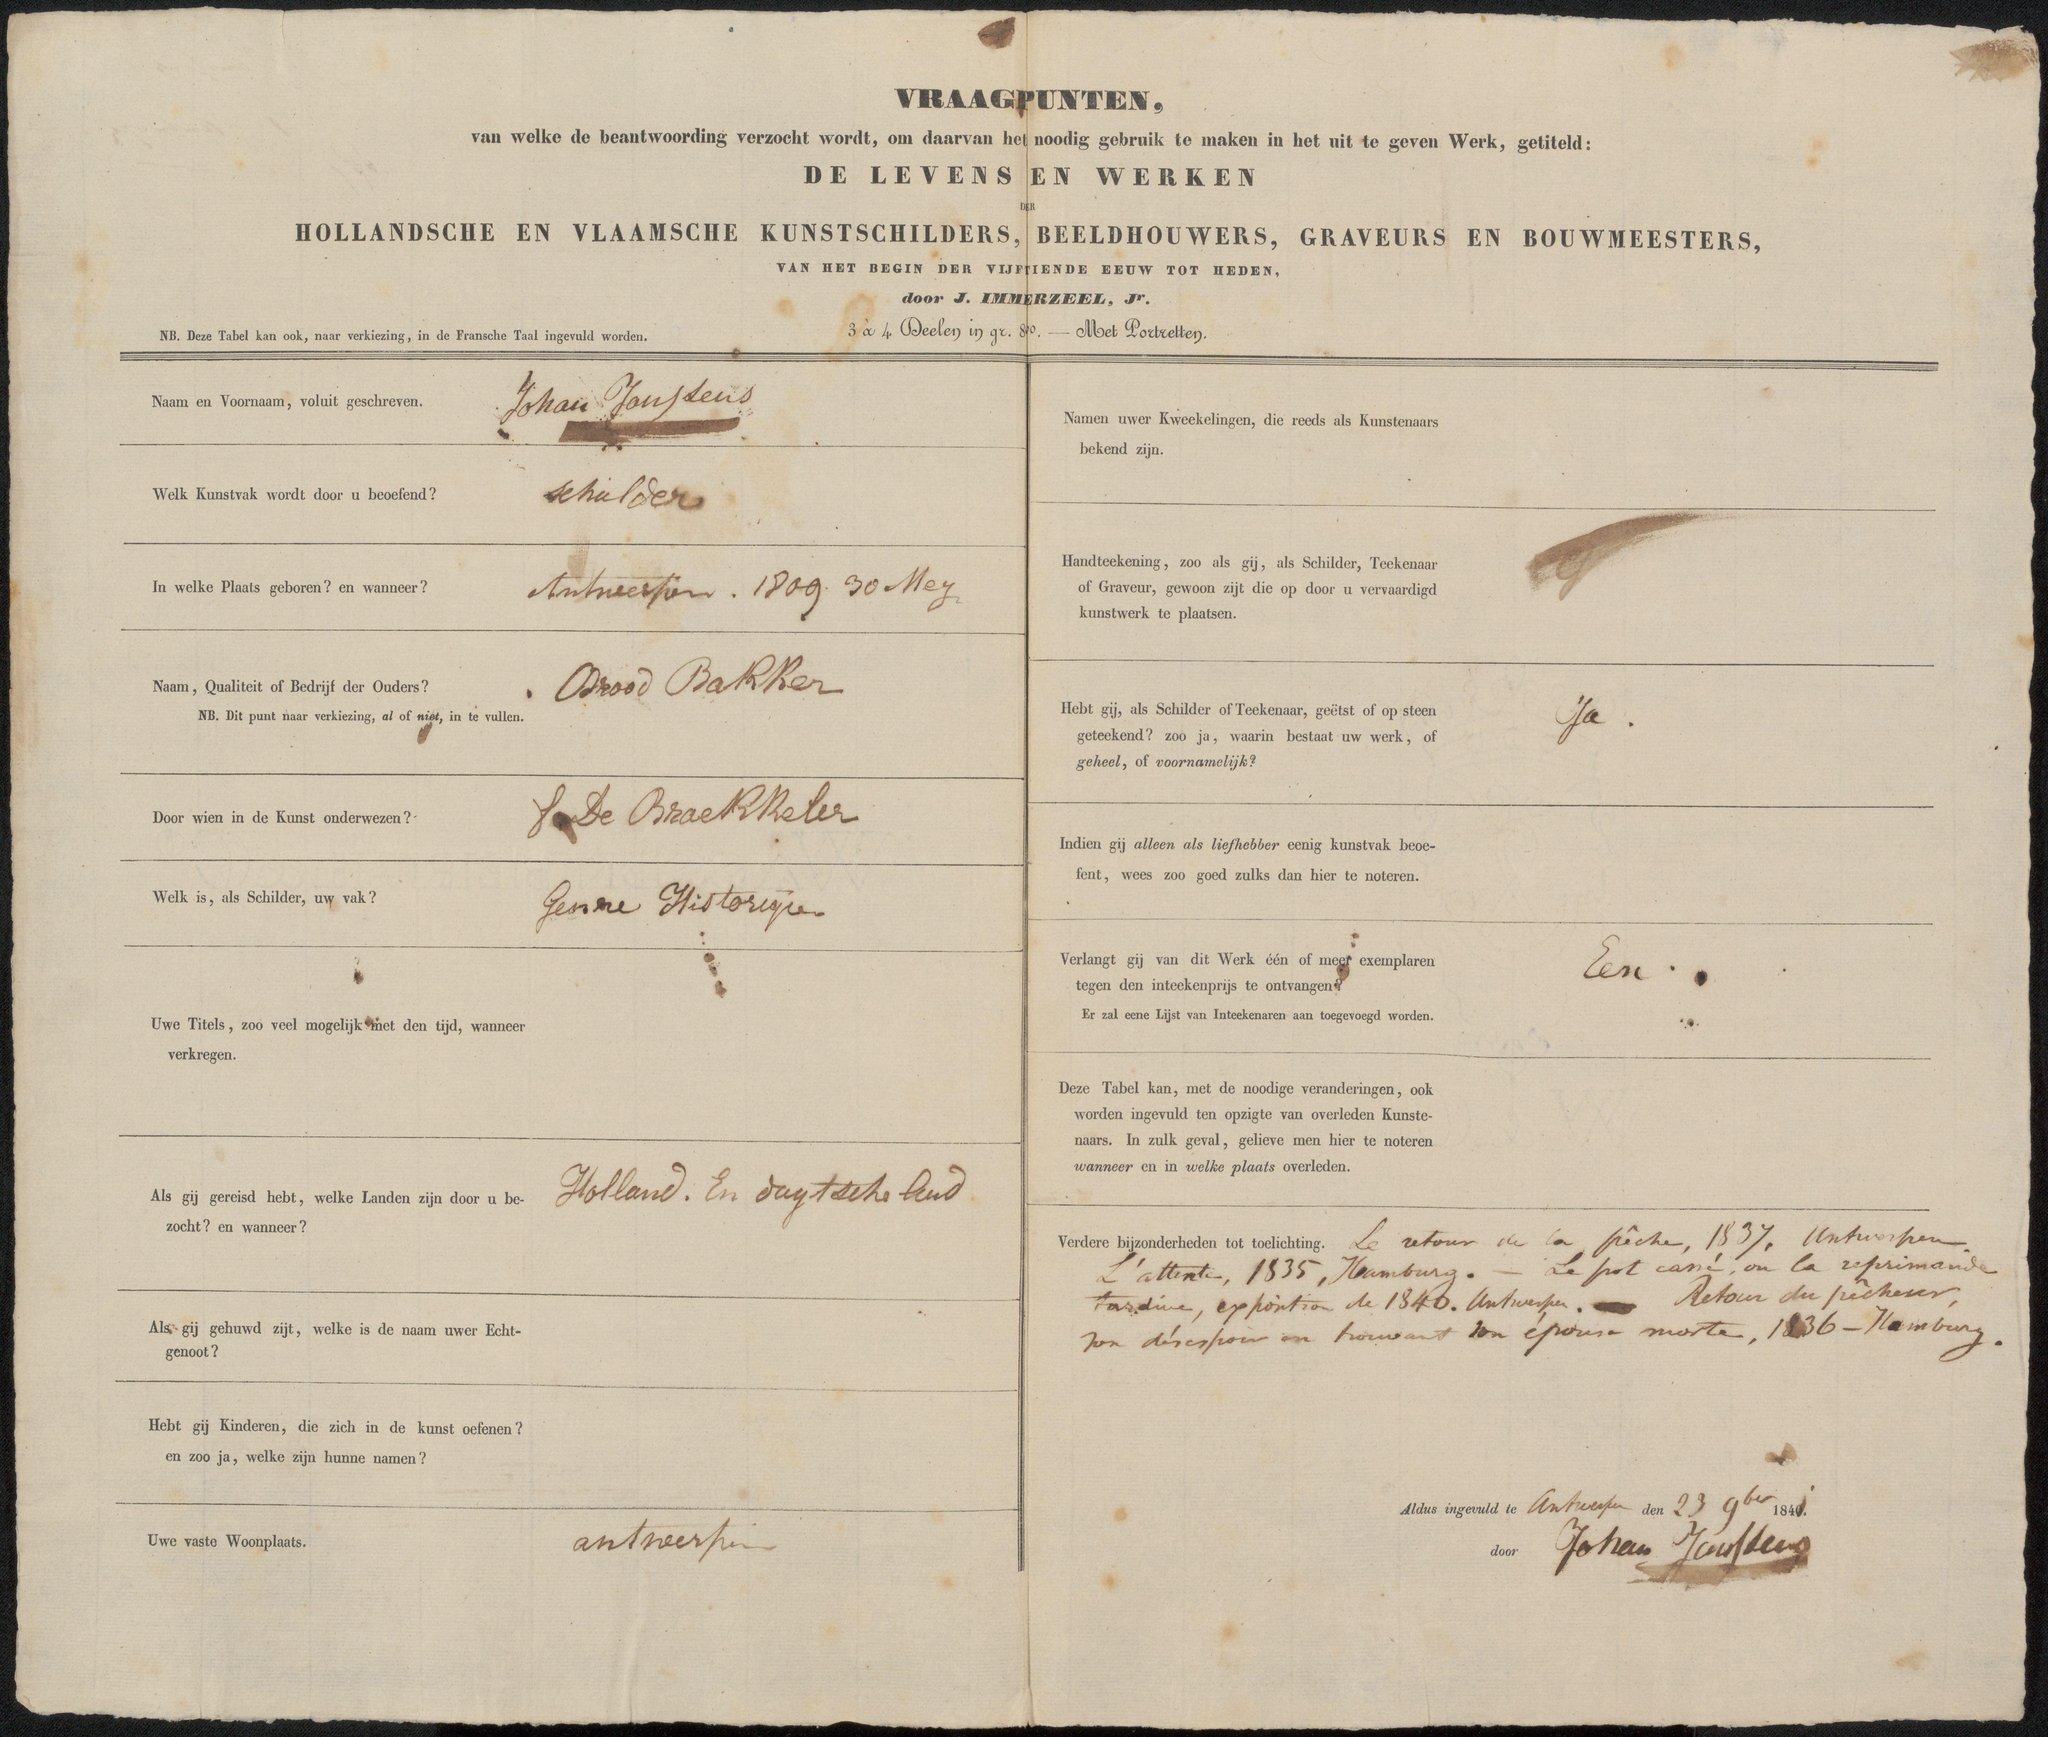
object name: manuscript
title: Enquêteformulier ingevuld door Johan Janssens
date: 1841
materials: ink, paper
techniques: pen, printing, writing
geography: antwerp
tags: painter, draughtsman, johan janssens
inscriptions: inscription: ‘Vraagpunten,/ van welke de beantwoording verzocht wordt, om daarvan het noodig gebruik te maken in het uit te geven Werk, getiteld: De levens en werken/ der Hollandsche en Vlaamsche kunstschilders, beeldhouwers,/ graveurs en bouwmeesters, van het begin der vijftiende eeuw tot heden/ door J. Immerzeel, Jr.’, watermark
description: Opgenomen in: Immerzeel, J. Jr., De levens en werken der Hollandsche en Vlaamsche kunstschilders, beeldhouwers, graveurs en bouwmeesters, van het begin der vijftiende eeuw tot heden, Amsterdam: J.C. van Kesteren, 1842-1843.